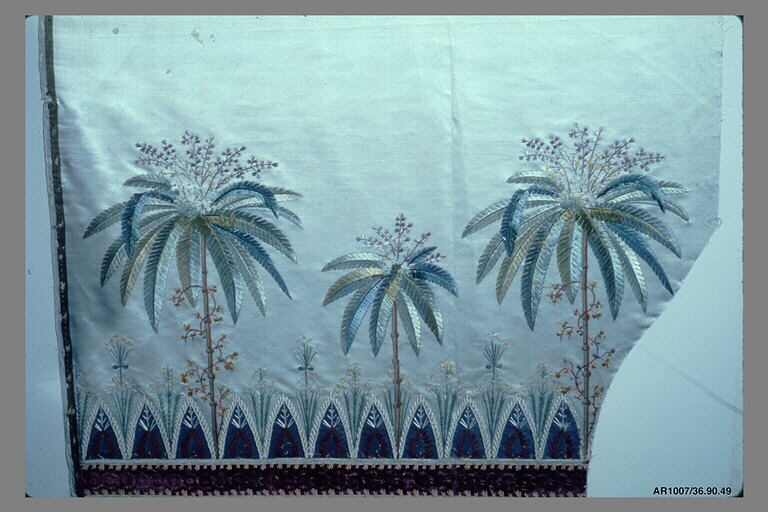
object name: border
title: Dress border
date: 1805-1815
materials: silk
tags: trees